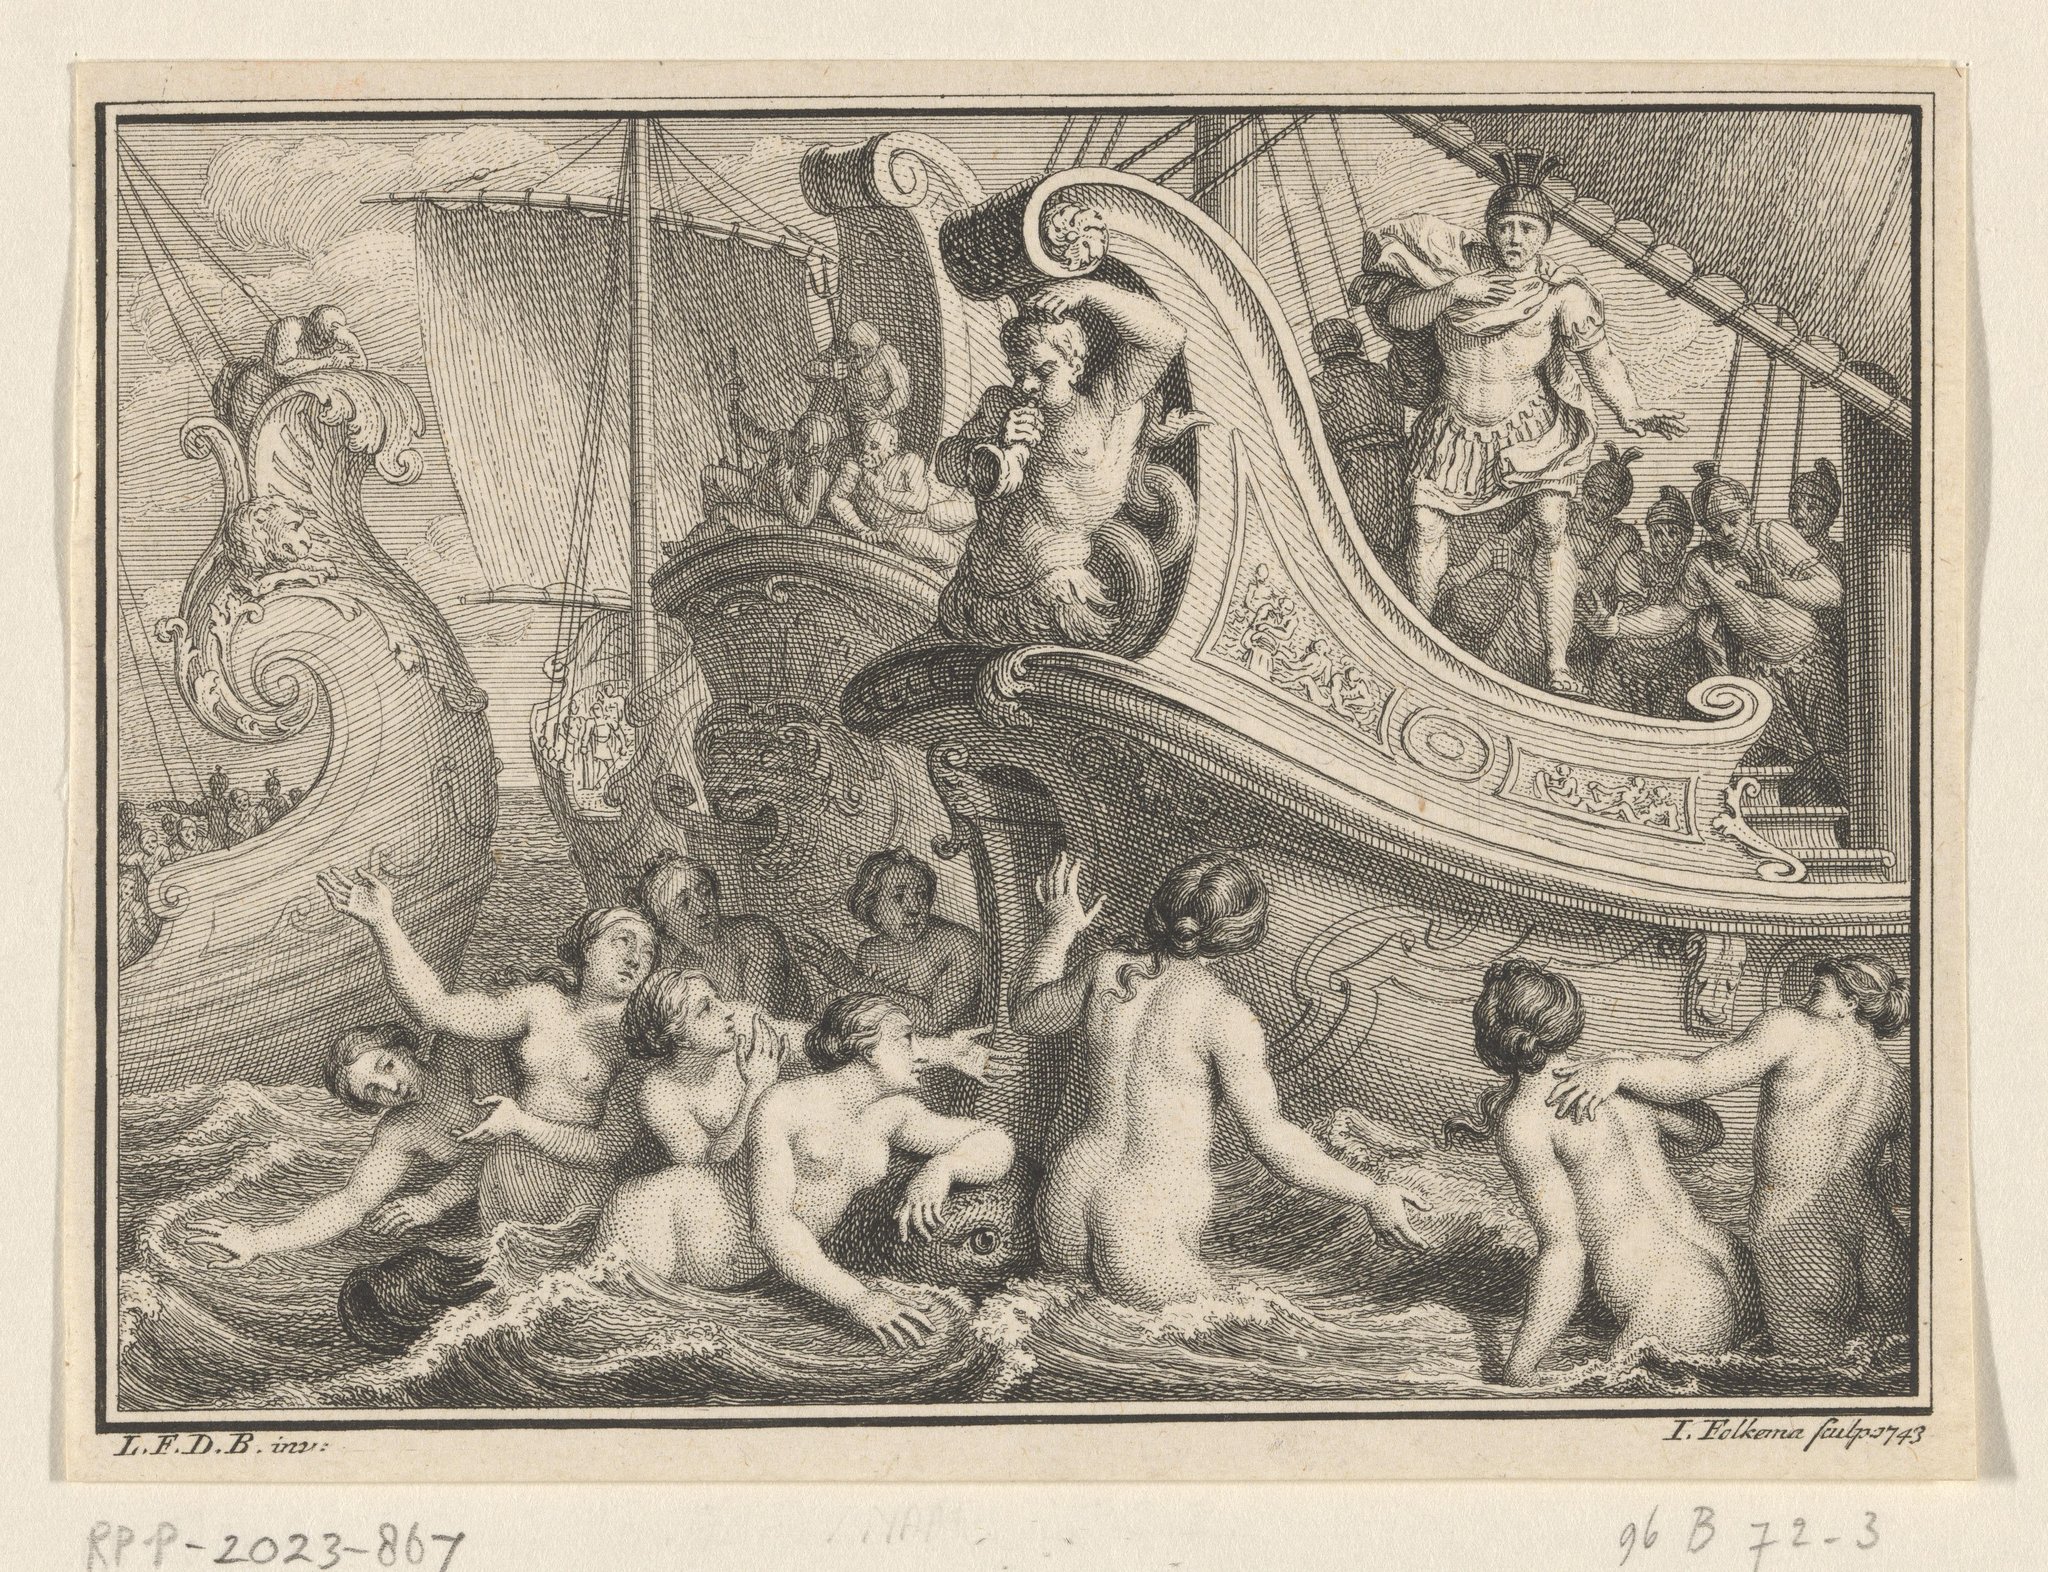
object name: print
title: Aeneas' vloot omringd door zeenimfen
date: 1743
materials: paper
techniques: engraving, etching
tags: sailing home aeneas encounters the nymphs, into which the burning ships were changed; they inform him about the besieged trojan camp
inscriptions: collector's mark: Lugt 2228, collector's mark: Lugt 699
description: Op zee komt Aeneas met zijn vloot een groep zeenimfen tegen die zijn boot omringen. Aeneas staat op het dek van zijn schip en bekijkt, samen met zijn bemanningsleden, de nimfen die zich rond zijn boot hebben verzameld.